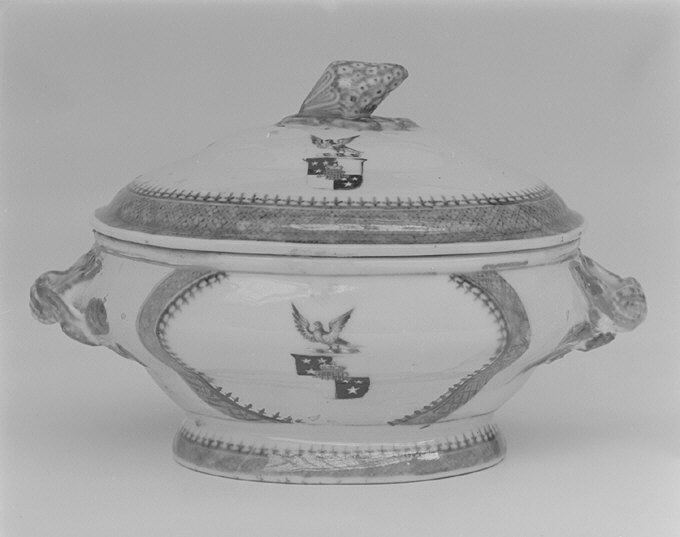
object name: tureen with cover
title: Tureen with cover (part of a service)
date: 1790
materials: hard paste porcelain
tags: birds,coat of arms